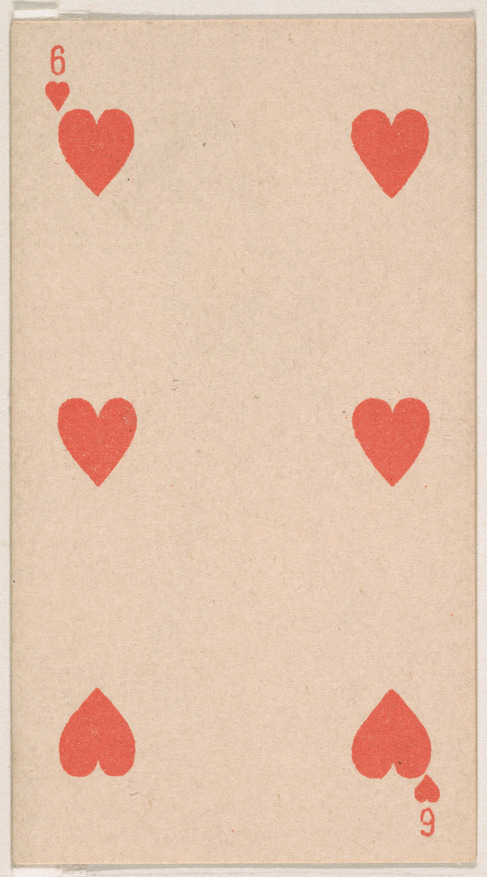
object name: print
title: Six of Hearts, from the Transparent Playing Cards series (N220) issued by Kinney Bros.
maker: kinney brothers tobacco company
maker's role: publisher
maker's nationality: american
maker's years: 1869-2011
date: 1888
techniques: color lithograph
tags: playing cards